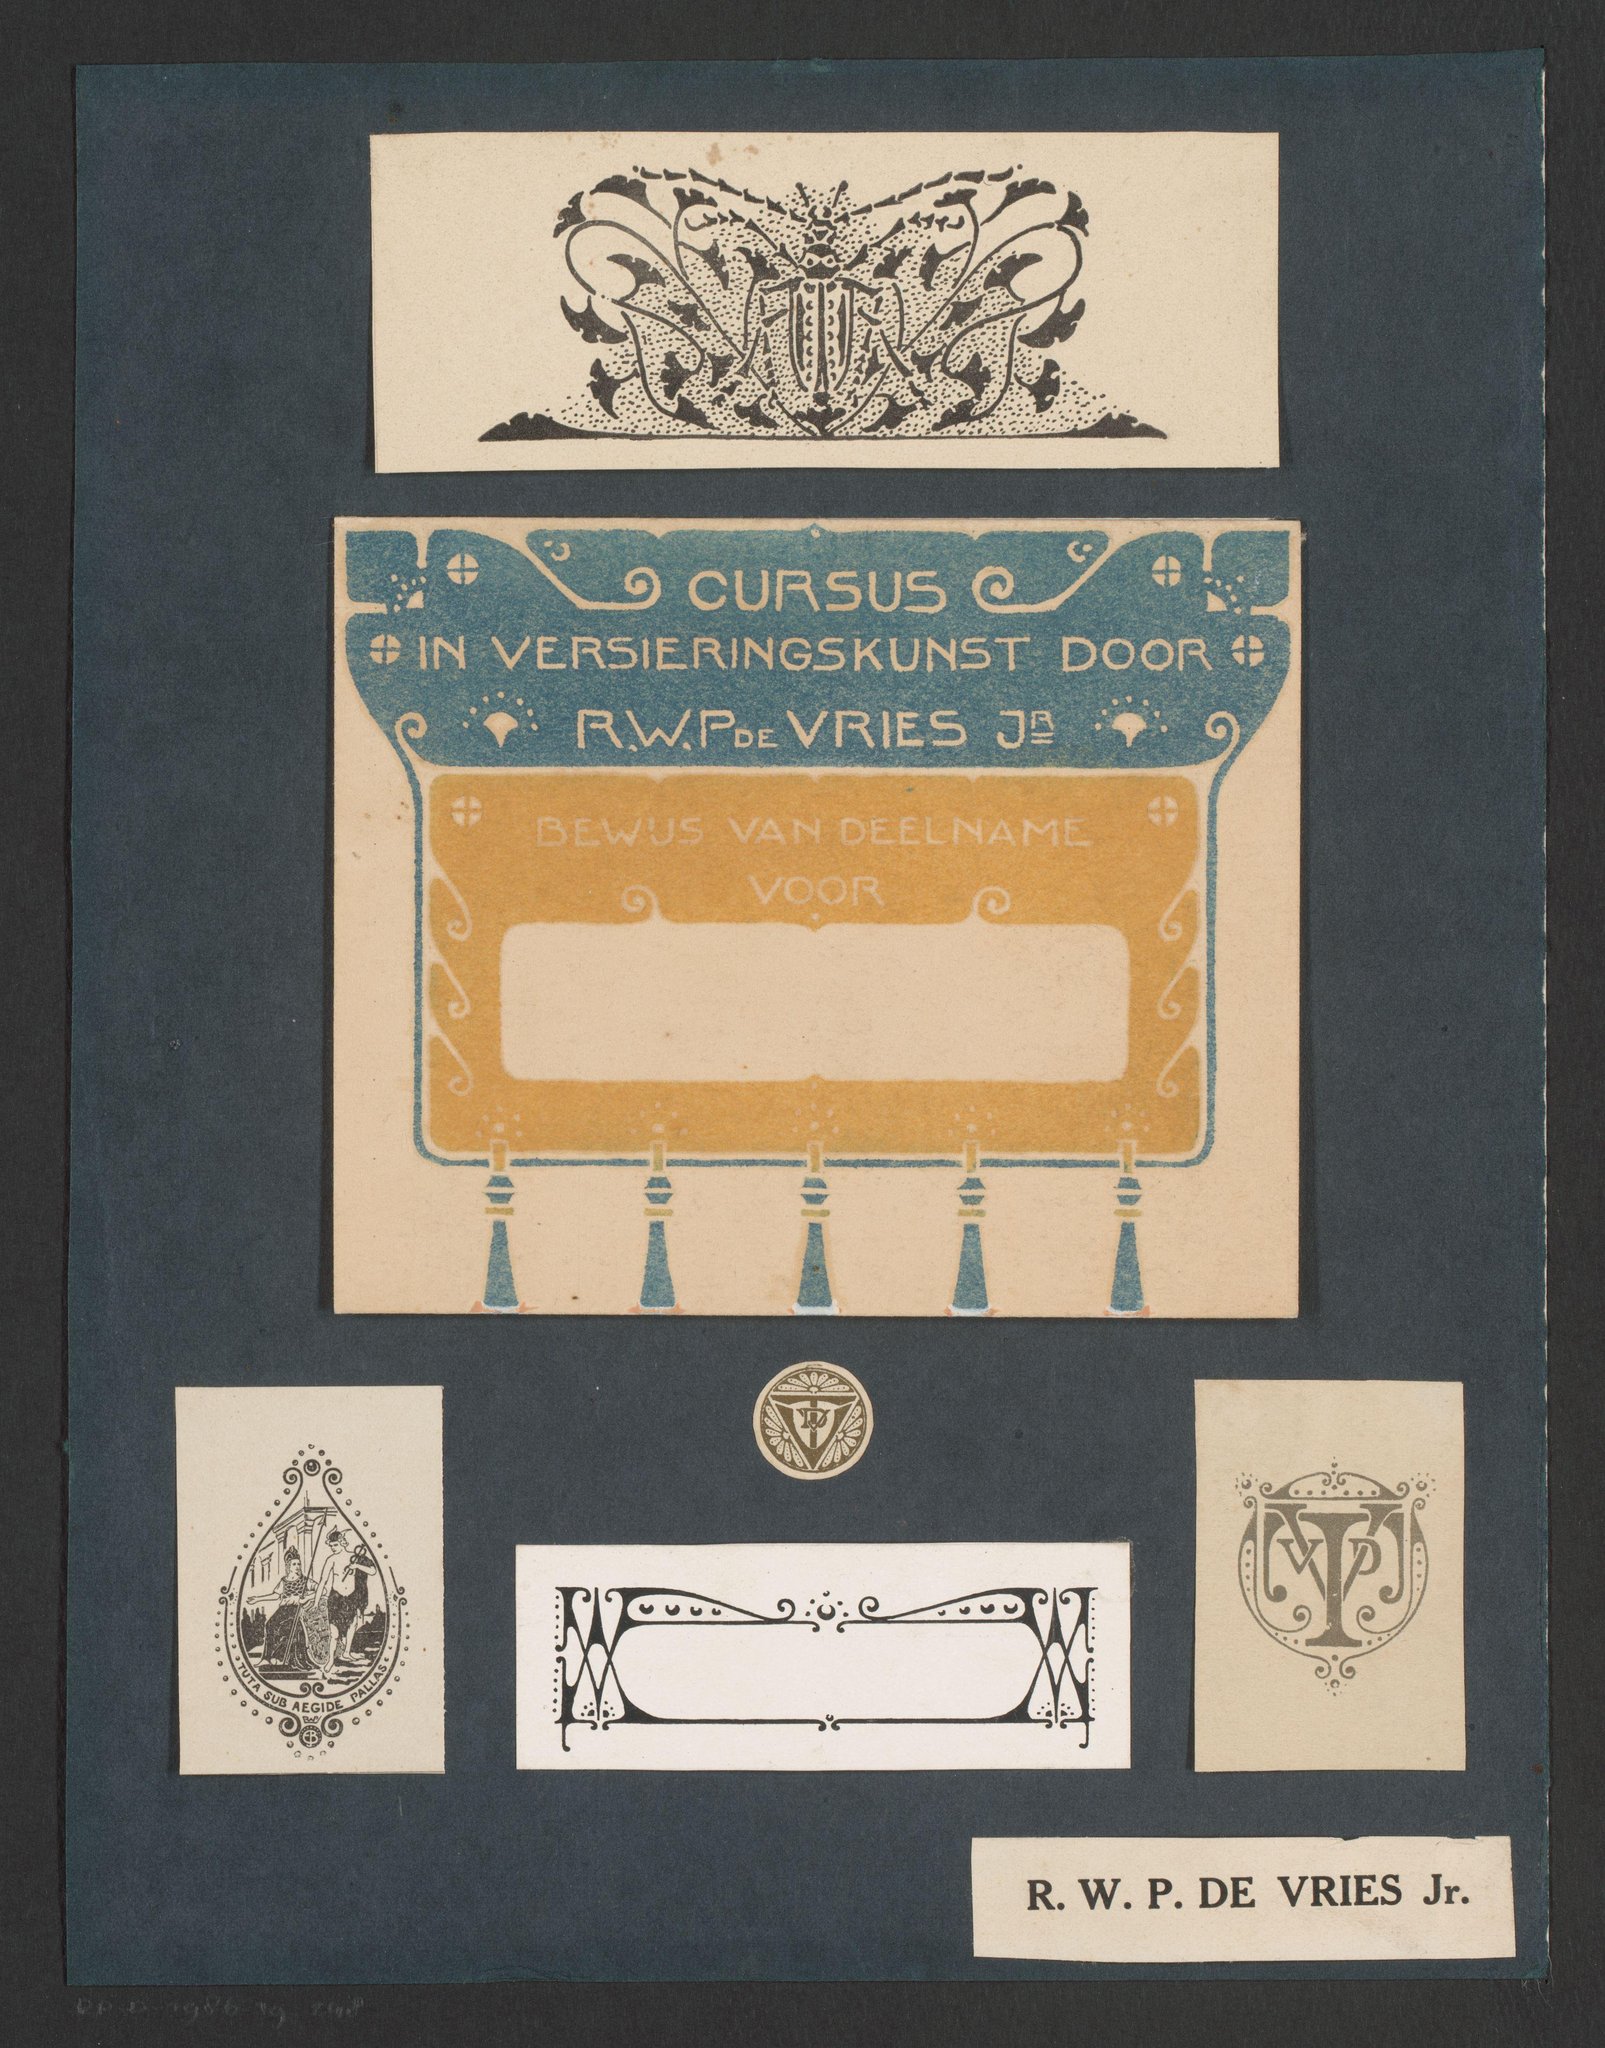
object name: print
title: Bewijs van deelname voor de cursus Versieringskunst door R.W.P. de Vries Jr., vignetten en monogrammen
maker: reinier willem petrus de vries (1874-1953)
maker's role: draughtsman, print maker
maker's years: 1874-1953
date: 1884-1952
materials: paint, paper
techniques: brush, lithograph, printing block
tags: (story of) pallas, magic mathematical figures; magic numbers, words, monograms, insects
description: Bovenaan een vignet met een insect en linksonder een uitgeversvignet van Uitgeverij Brill (Tuta sub aegide Pallas). In het midden het bewijs van deelname voor de cursus Versieringskunst door R.W.P. de Vries Jr. Midden en rechtsonder monogrammen met de letters IVvdM(?) en TVvD(?).